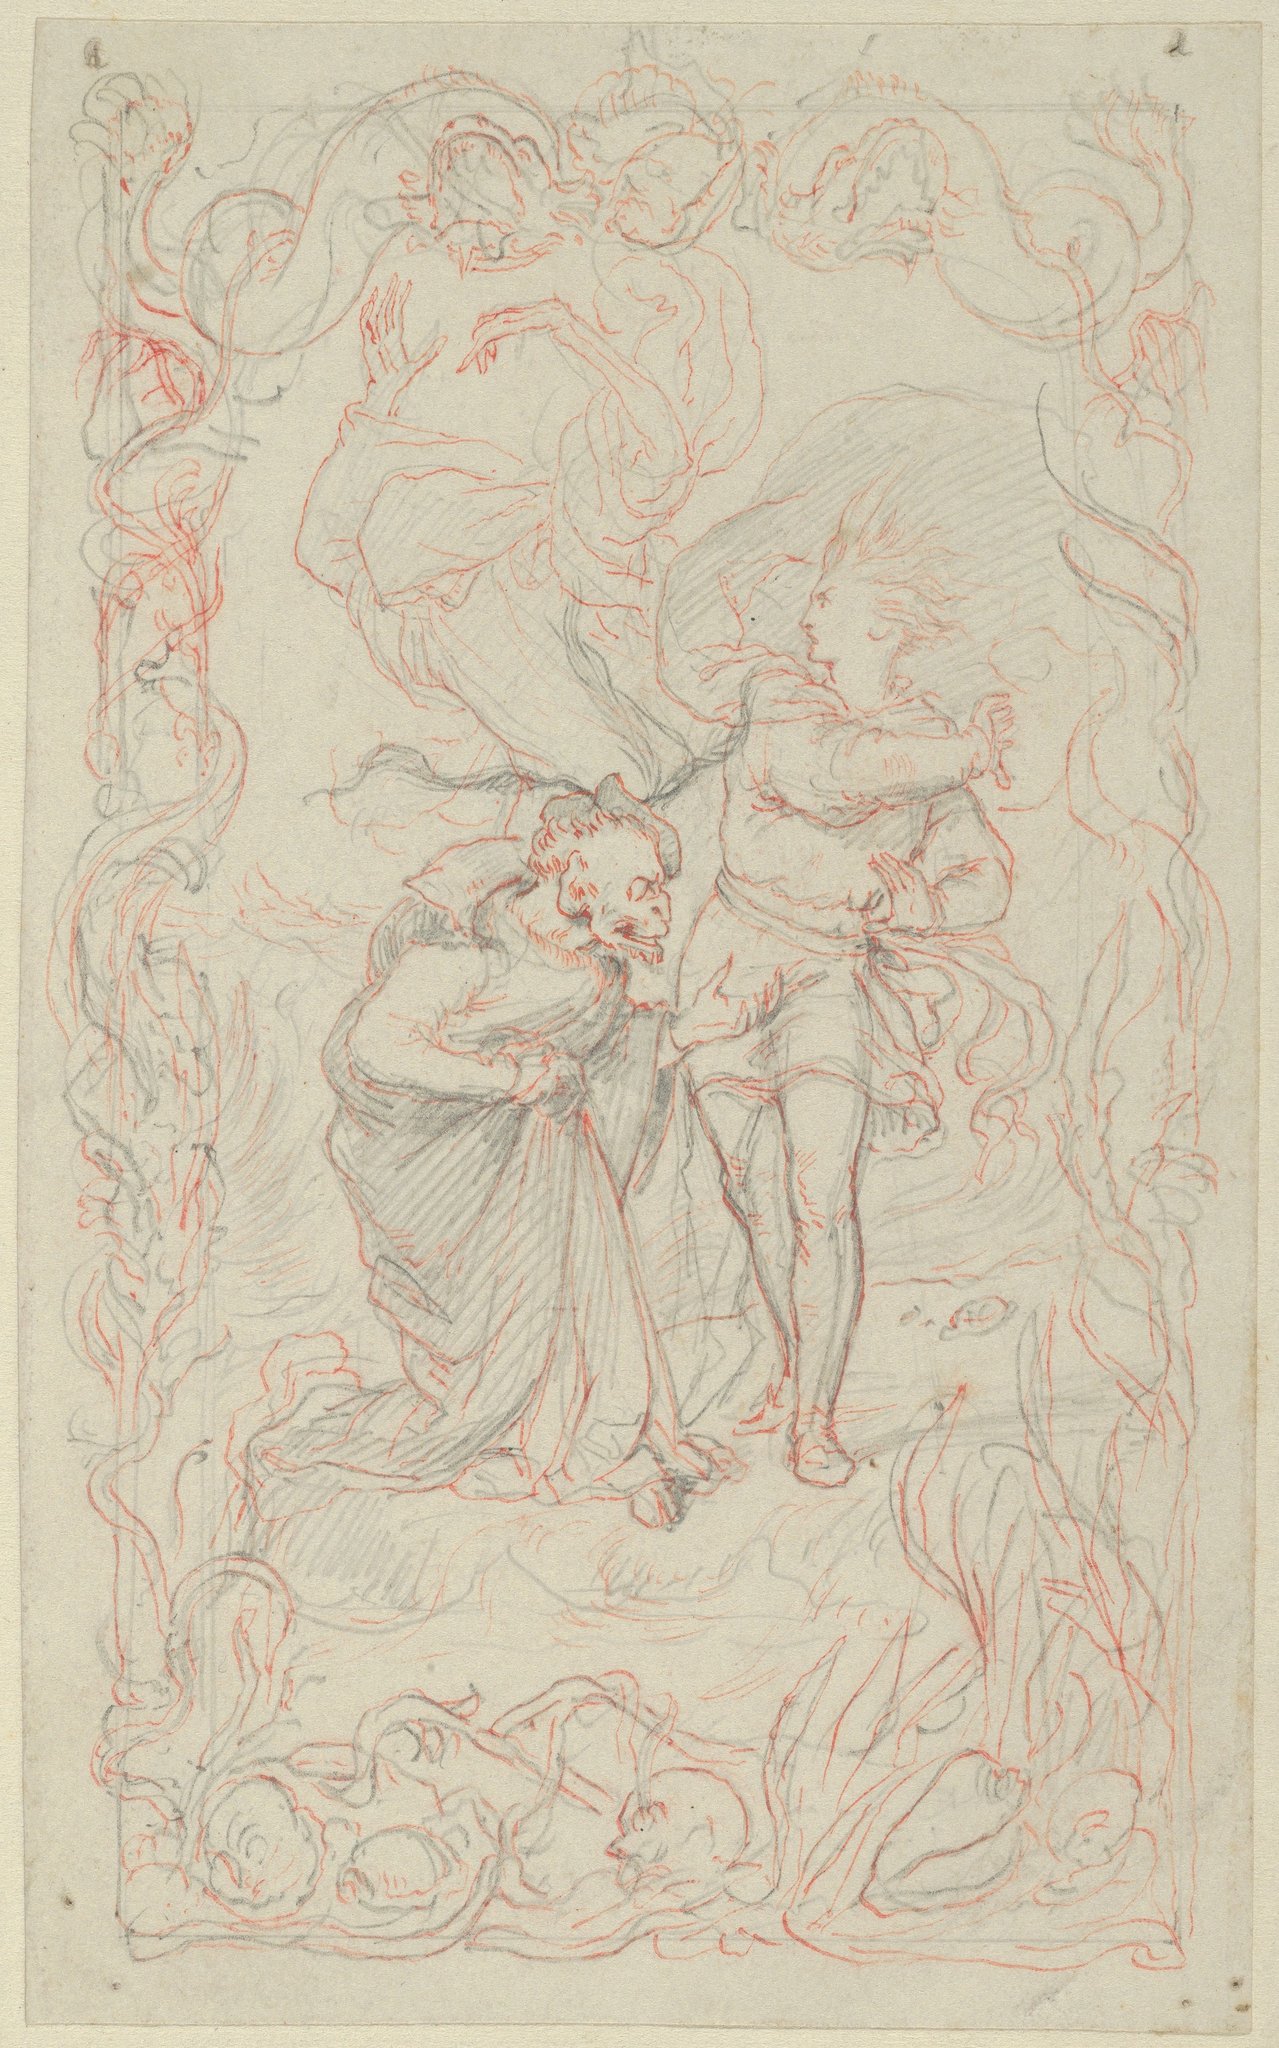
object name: drawing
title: Illustration to the Tempest: Caliban, Ferdinand and Ariel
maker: henry courtney selous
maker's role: artist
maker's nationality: british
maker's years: 1803-1890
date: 1836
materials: graphite, ink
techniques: pen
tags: shakespeare,men